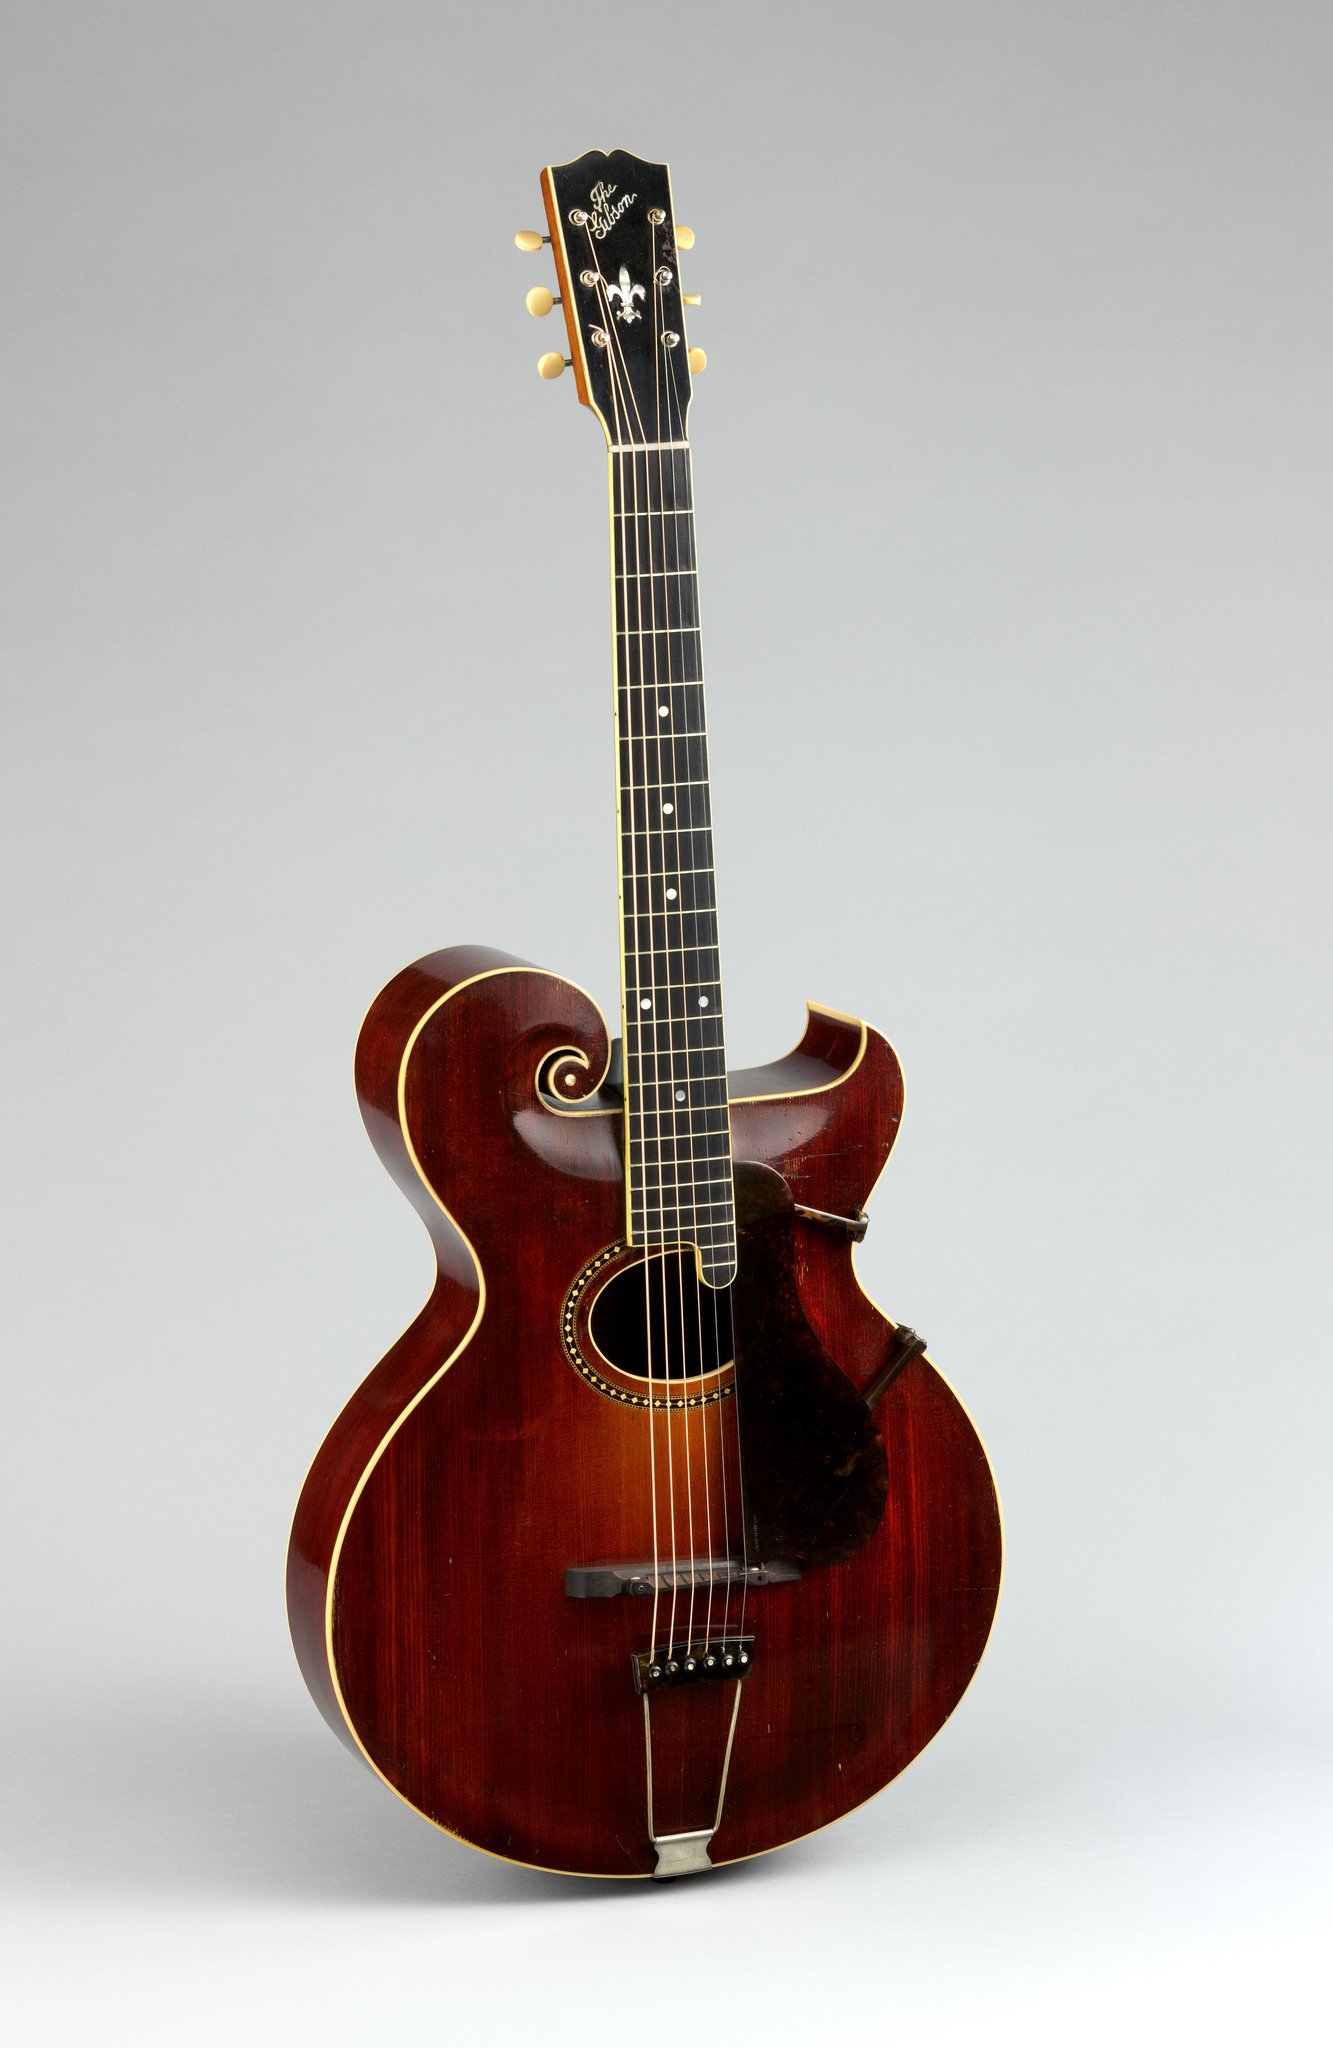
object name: archtop guitar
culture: american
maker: gibson mandolin-guitar manufacturing co., ltd.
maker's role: maker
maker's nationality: american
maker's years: 1902-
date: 1919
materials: wood, mother of pearl, nickel, silver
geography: united states